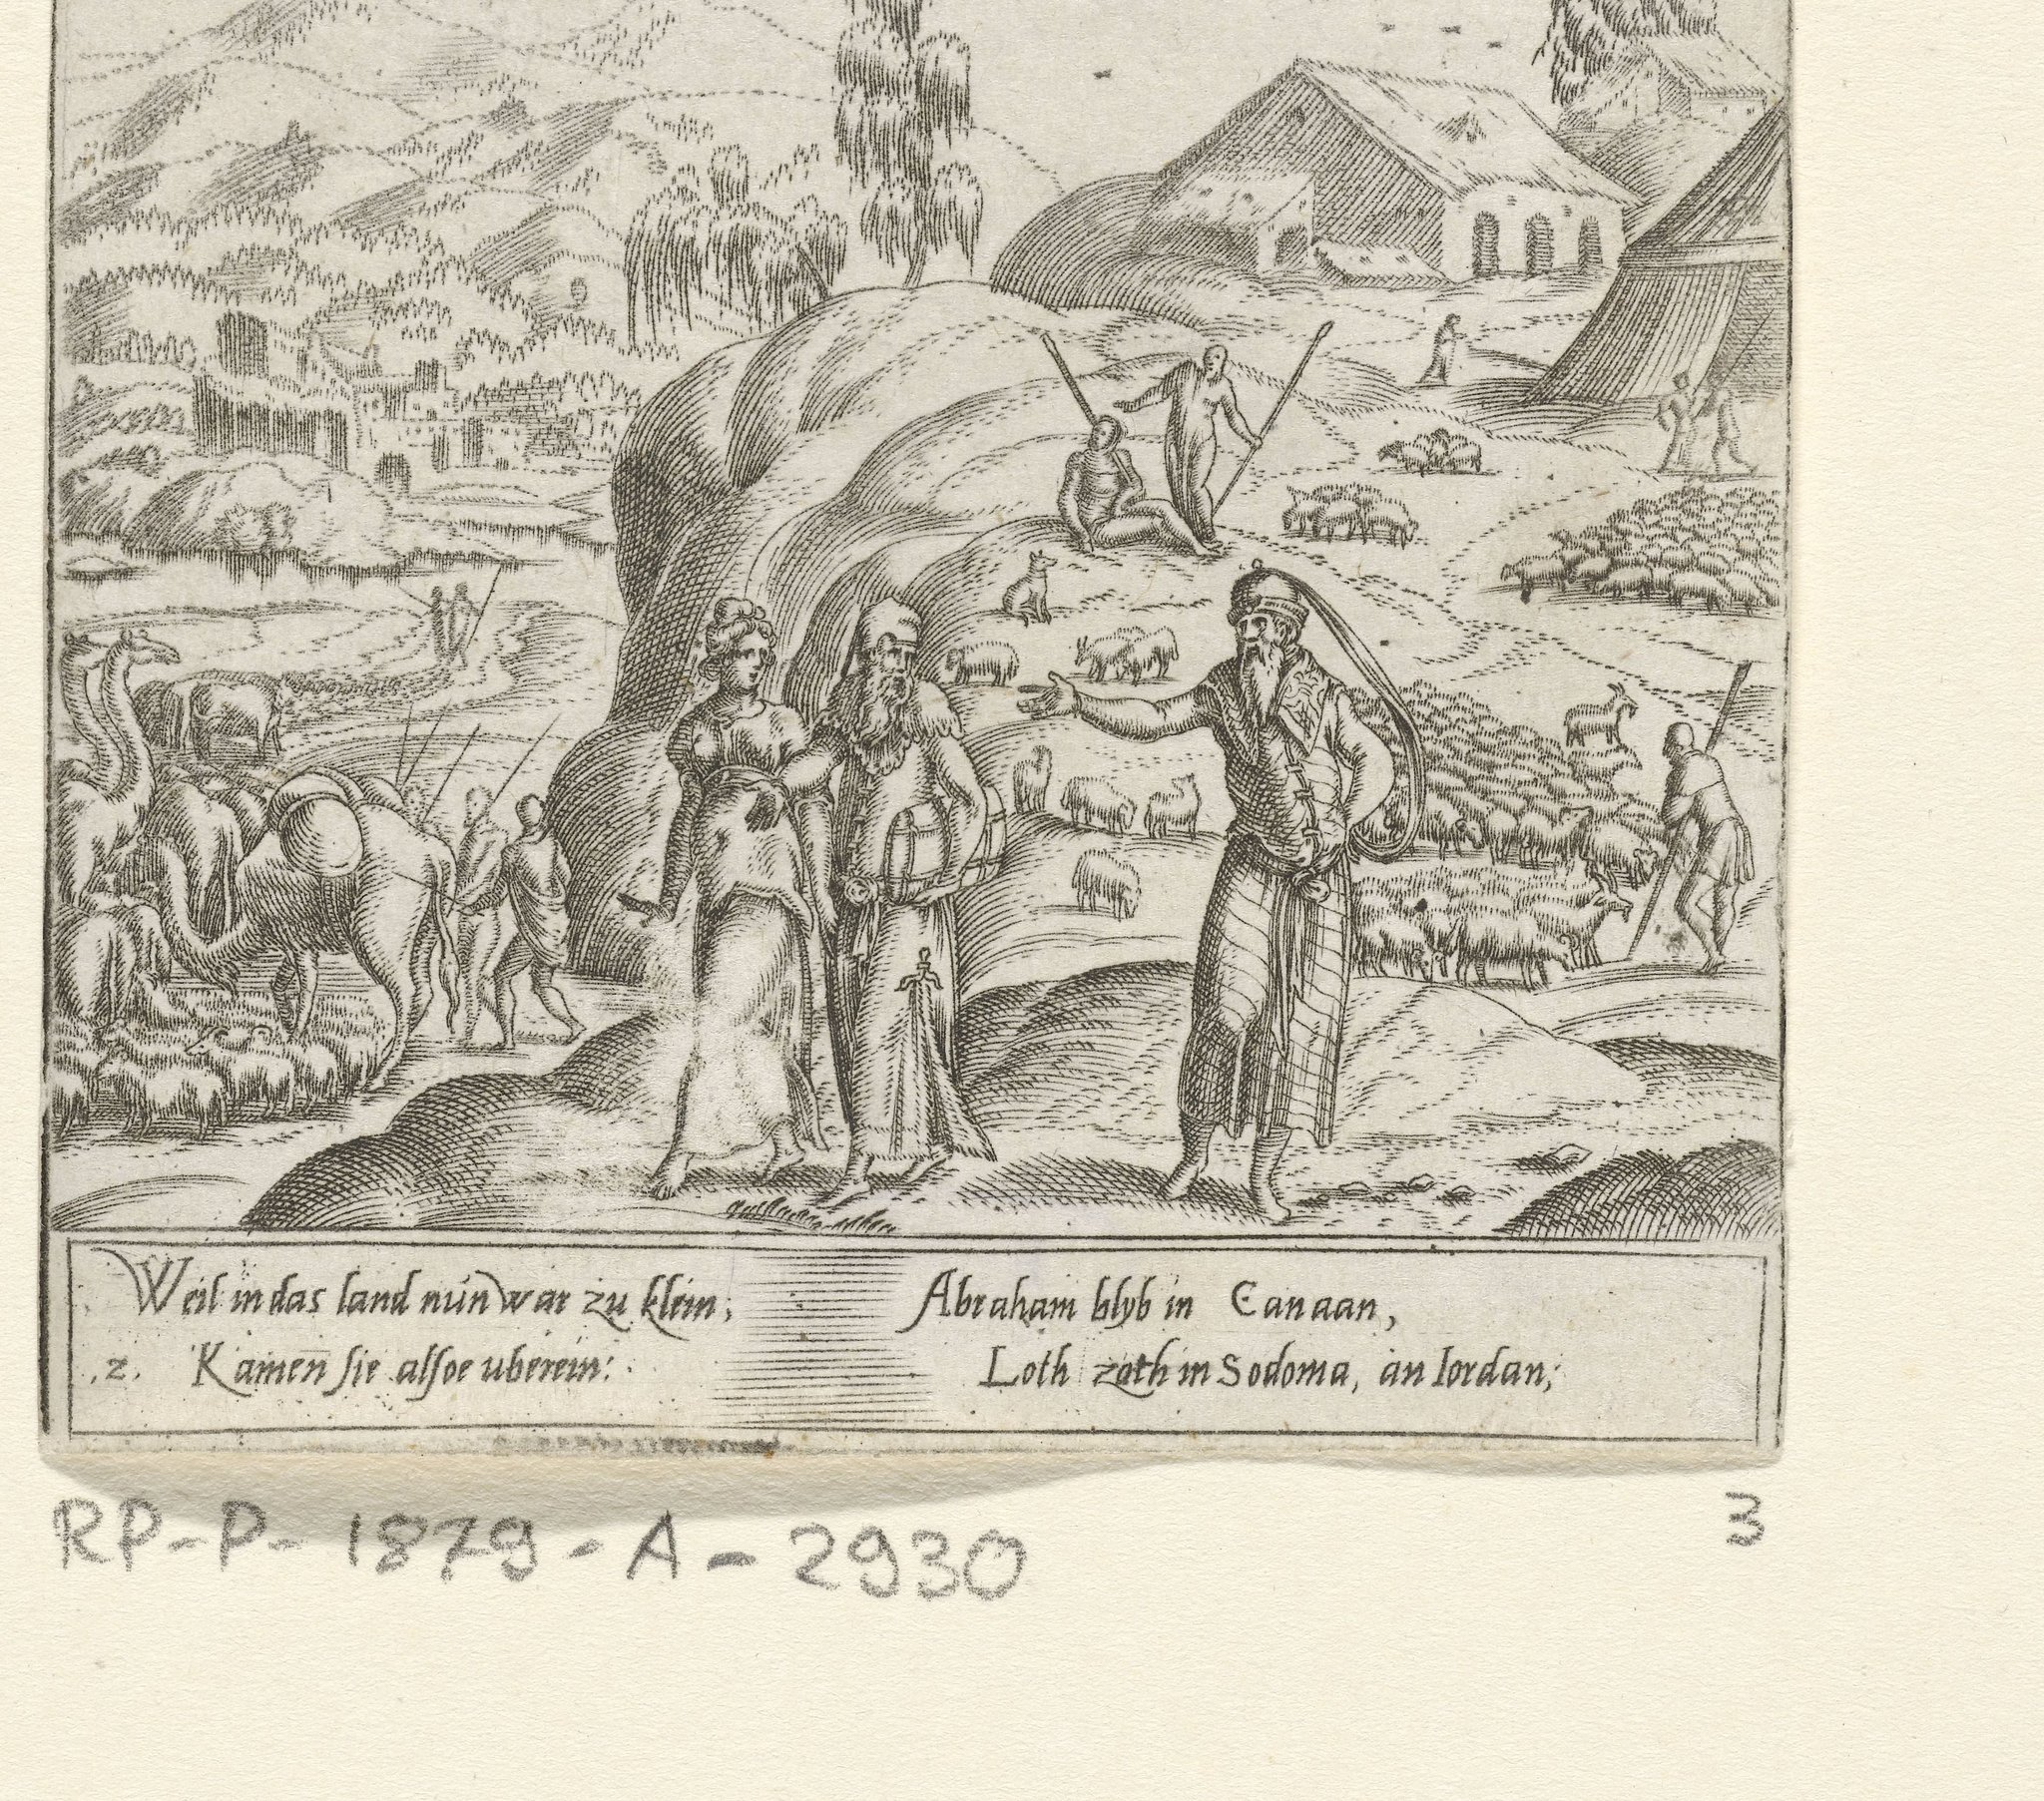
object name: print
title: Afscheid van Abraham en Loth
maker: cornelis bos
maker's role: print maker, printer, publisher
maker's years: 1510-1566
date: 1555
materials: paper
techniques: engraving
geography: groningen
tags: abraham and lot separating (genesis 13)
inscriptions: collector's mark: Lugt 2228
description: Omdat er ruzie ontstaat tussen de herders van Loth en Abraham gaan deze uit elkaar. Loth trekt met zijn mensen naar het gebied om de stad Sodom, Abraham blijft in Kanaän. Prent uit een serie van 12 prenten met het leven van Abraham. Alle prenten hebben vier regels Duitse verklarende tekst in de ondermarge.